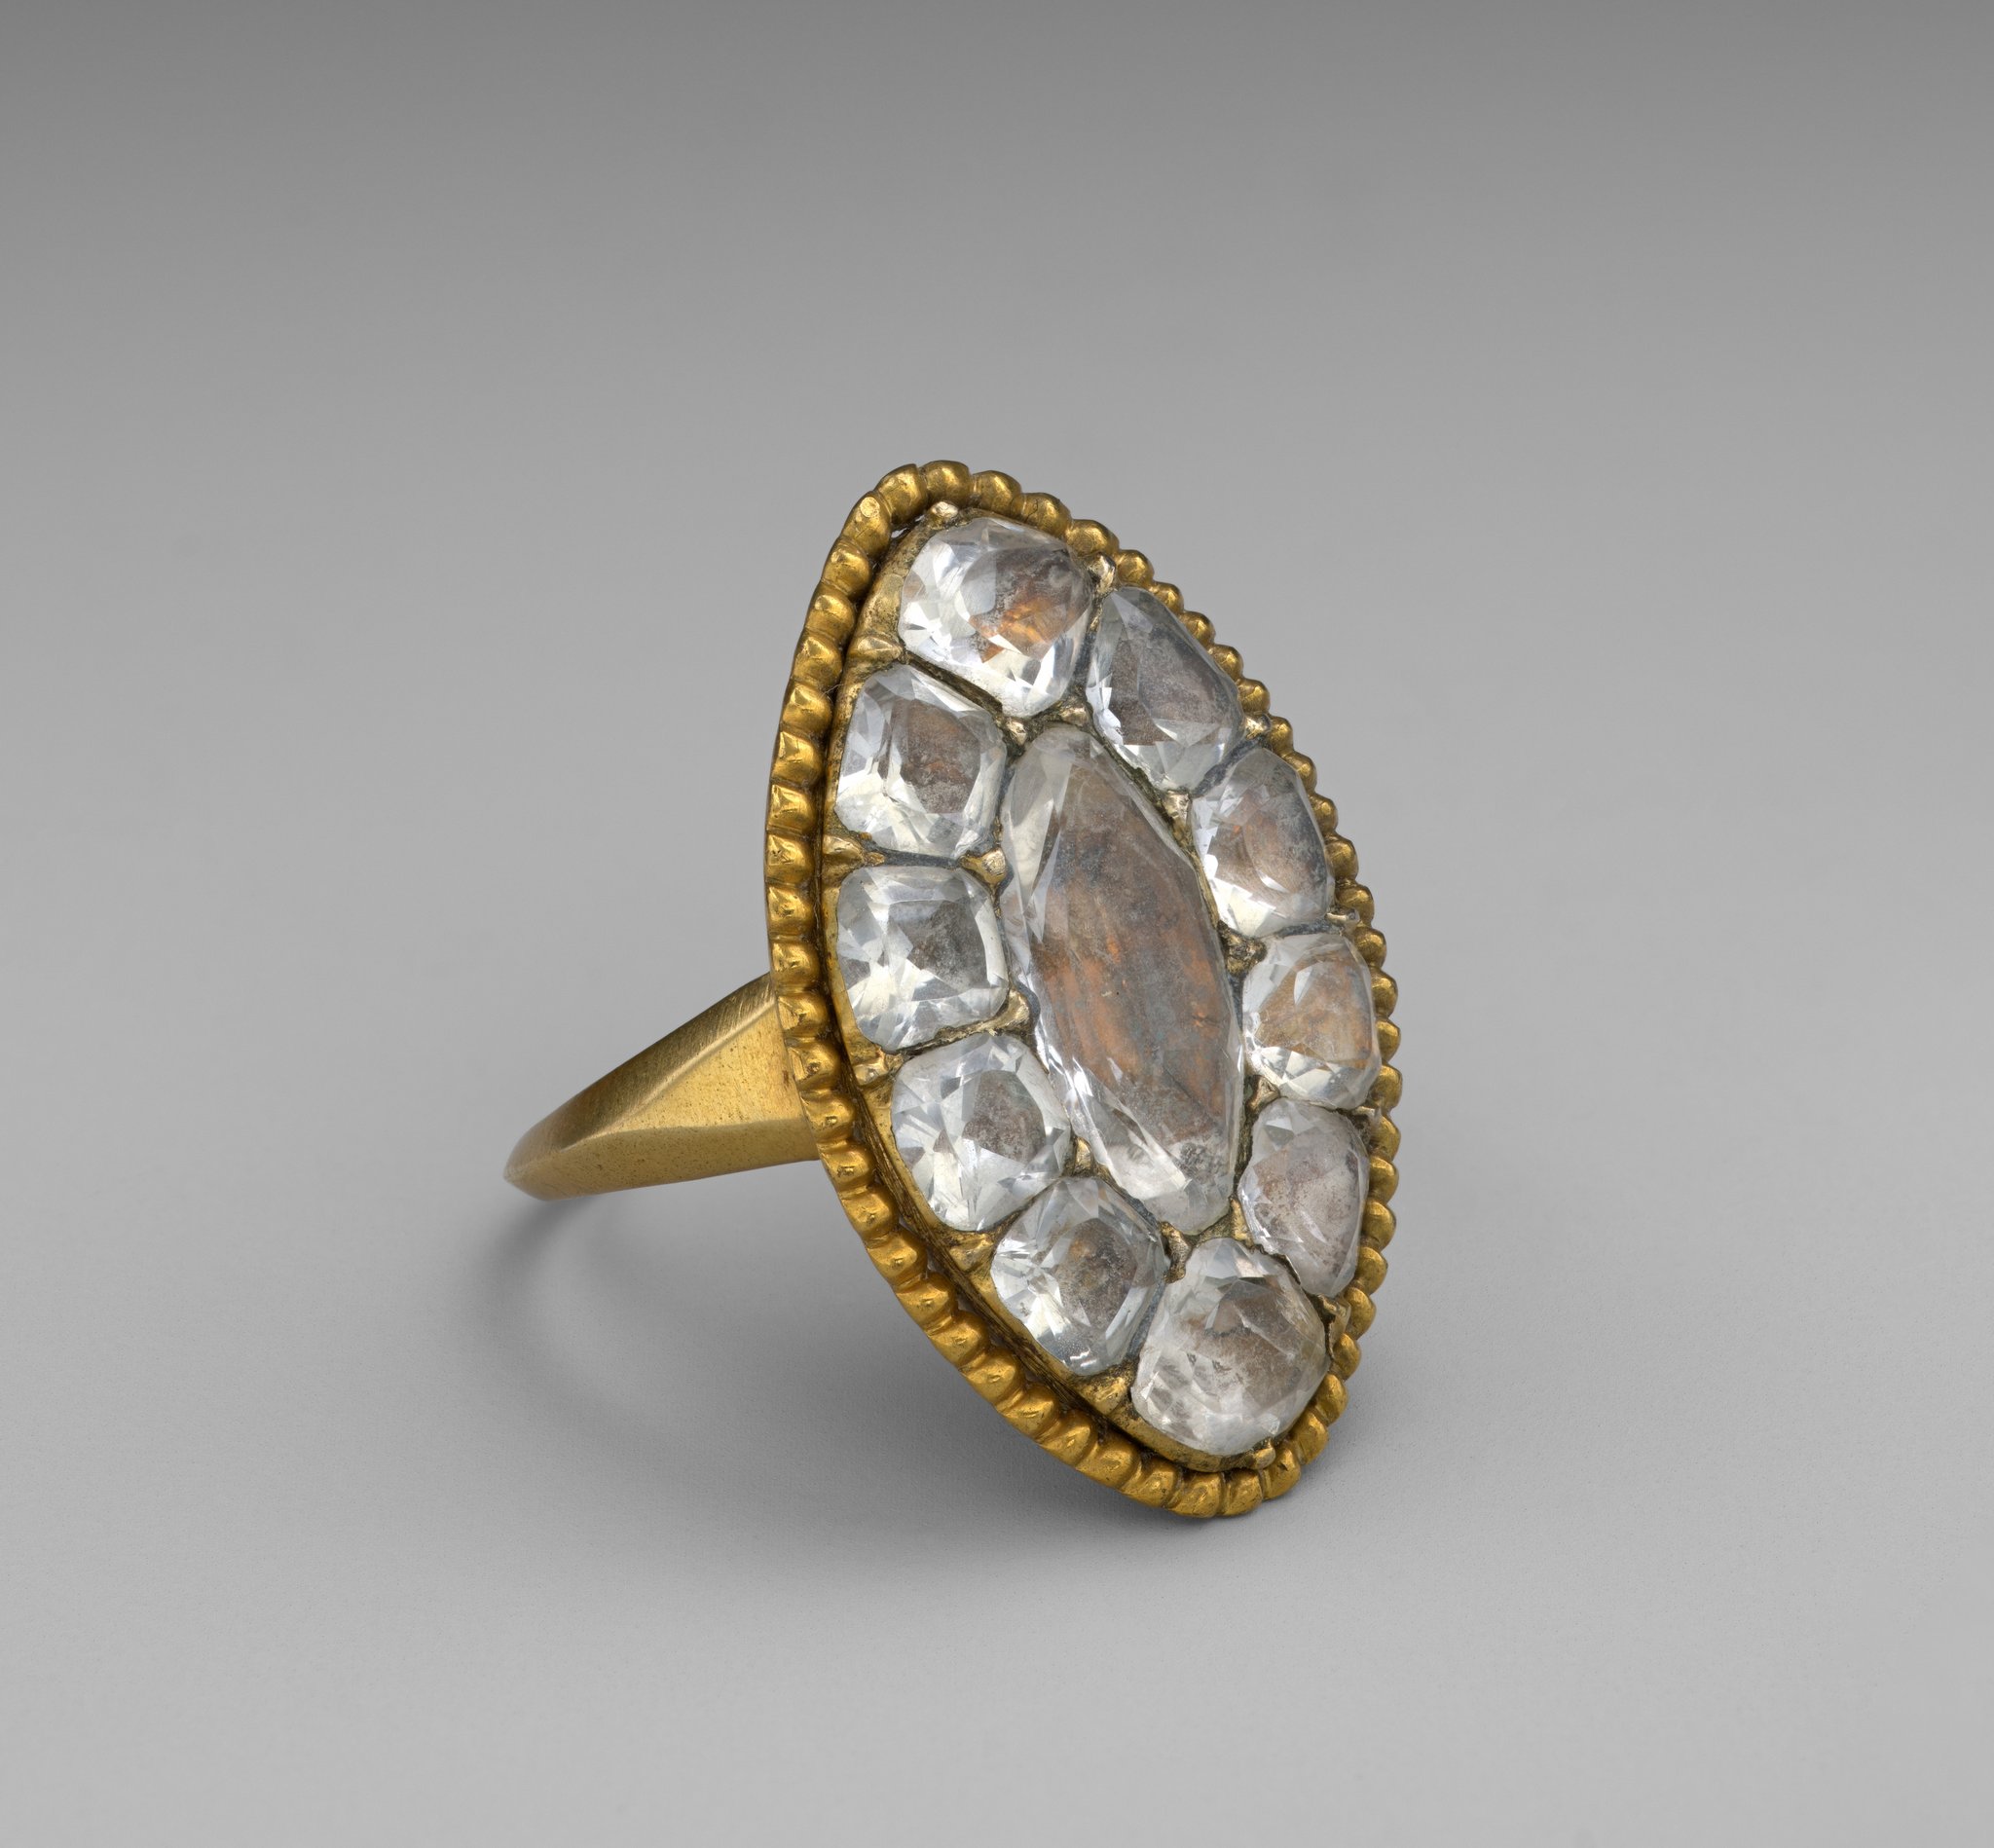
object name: ring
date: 1801-1833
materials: gold, gemstone